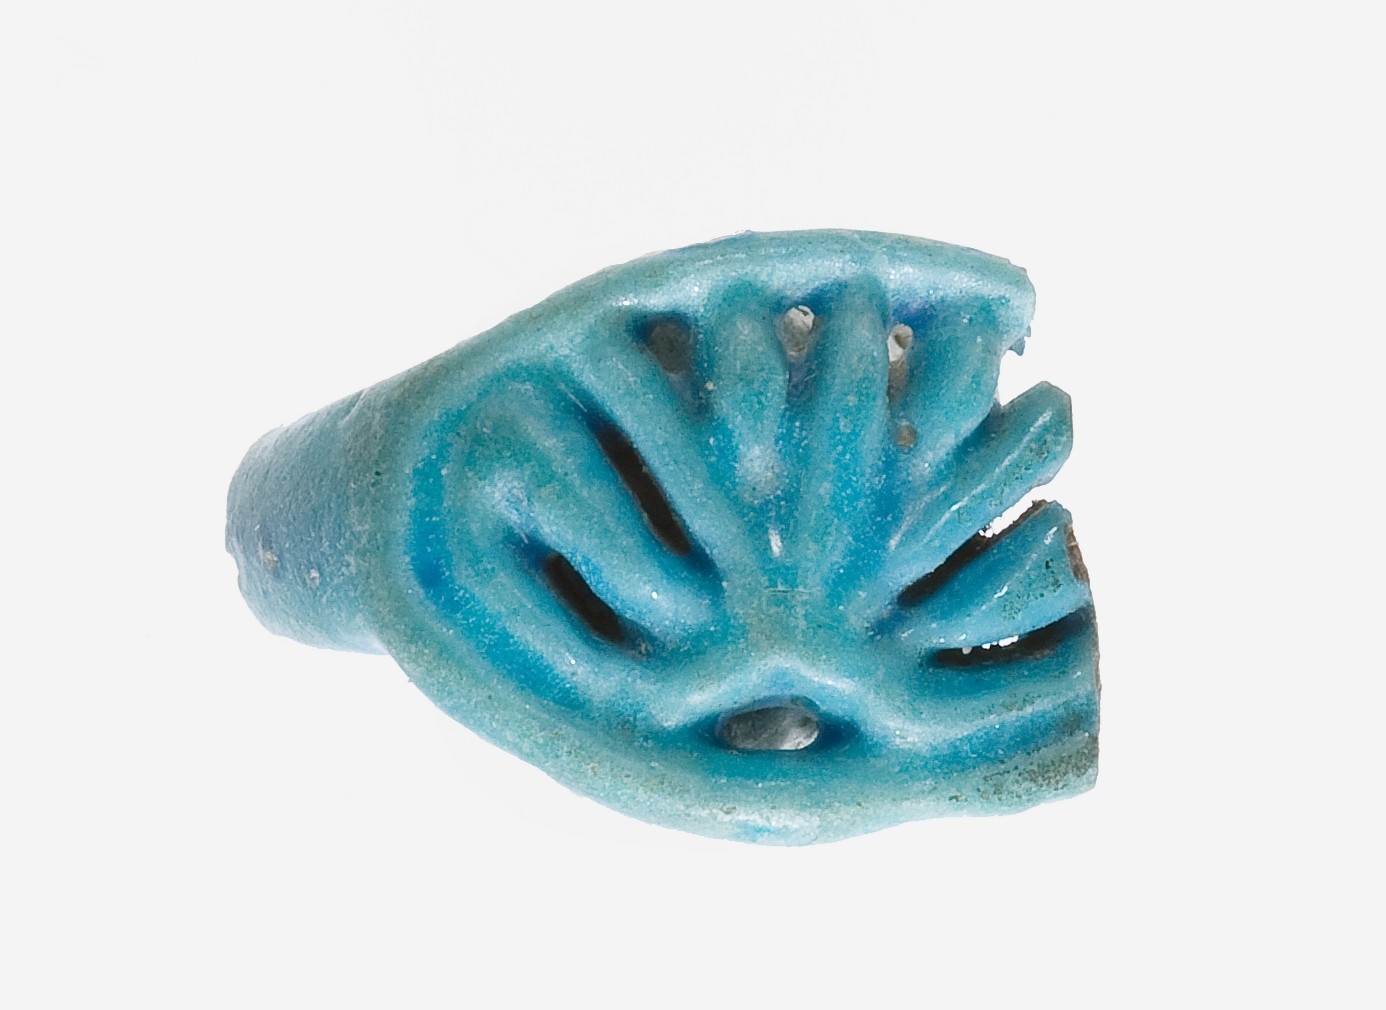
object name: ring fragment, floral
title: Fragment of a Floral Ring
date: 1390-1352 BCE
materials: faience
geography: egypt